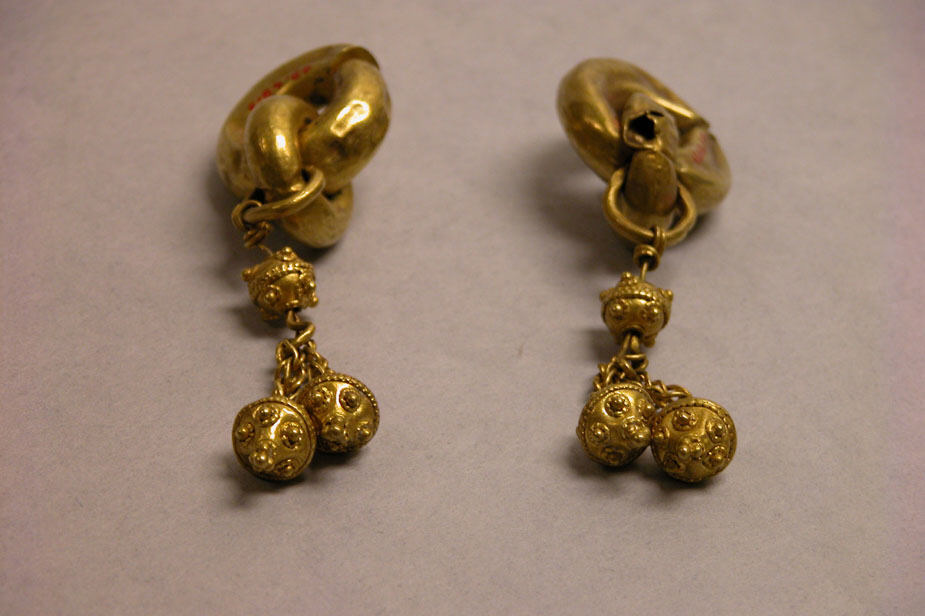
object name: earring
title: Earring (one of a pair)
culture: korean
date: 501-600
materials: gold